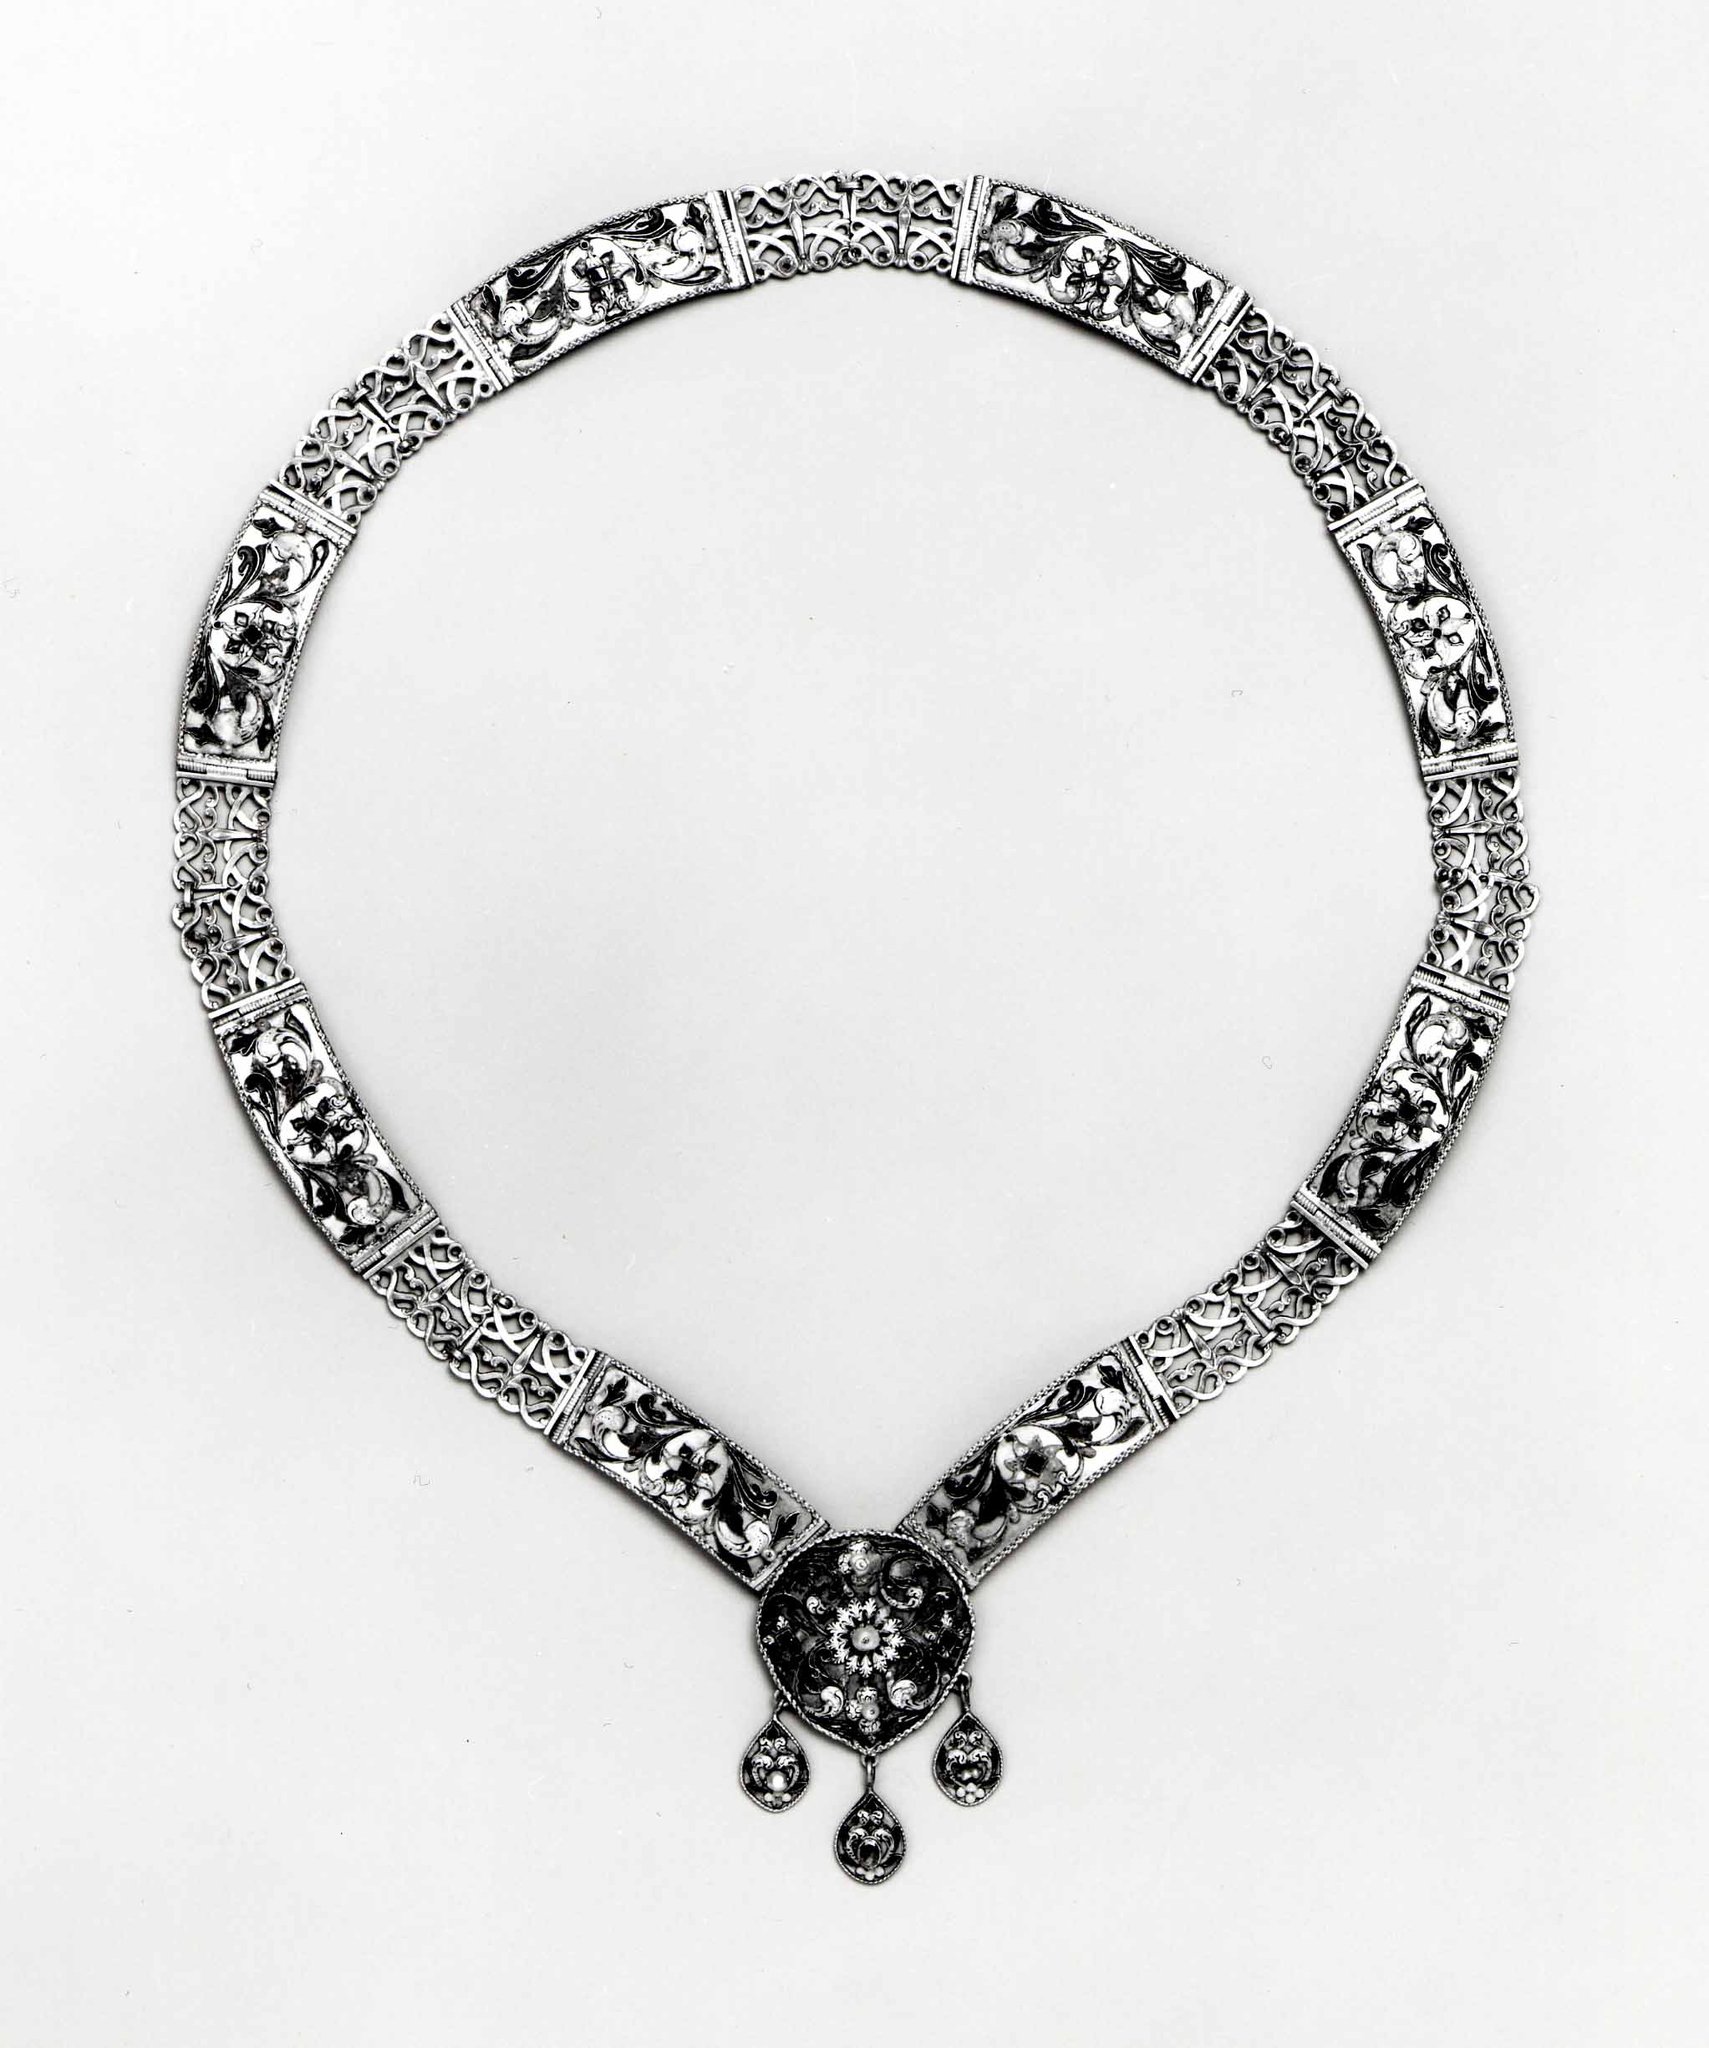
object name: girdle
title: Belt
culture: transylvanian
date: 1651-1700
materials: enamel, pearl, silver gilt, stone